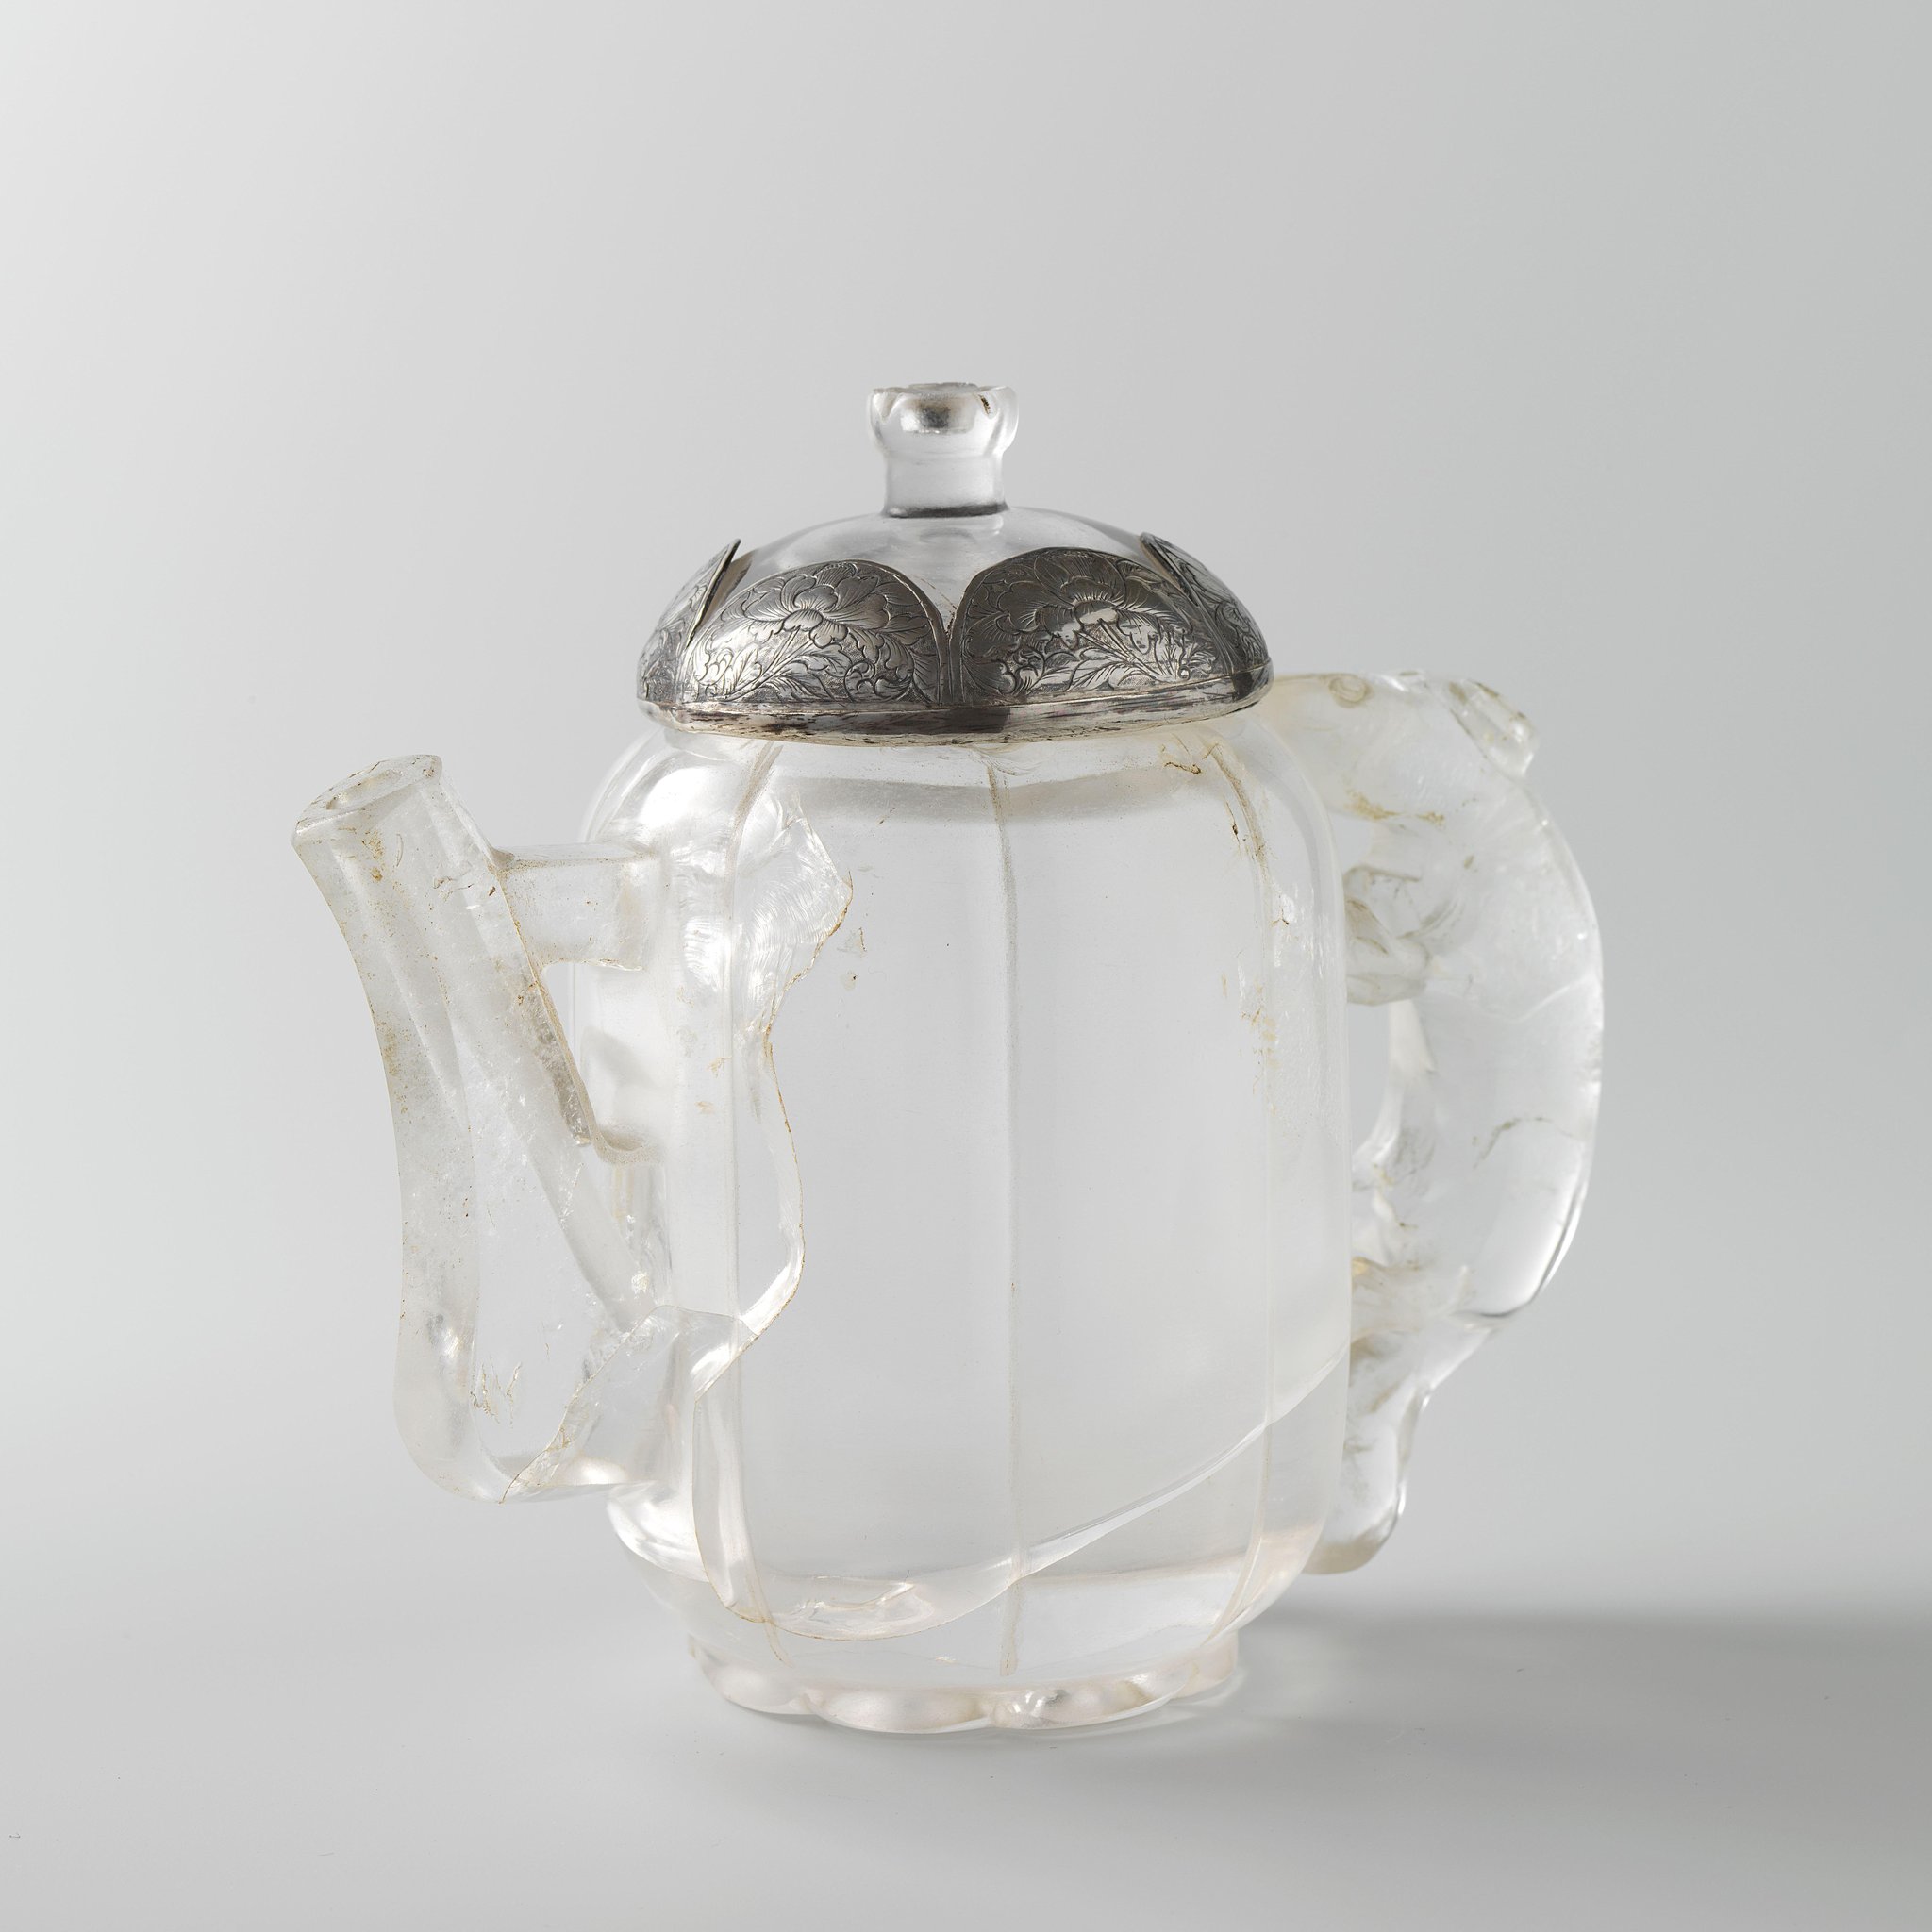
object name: ewer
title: Wine jug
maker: Anonymous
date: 1700-1800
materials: crystal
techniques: bergkristal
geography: china